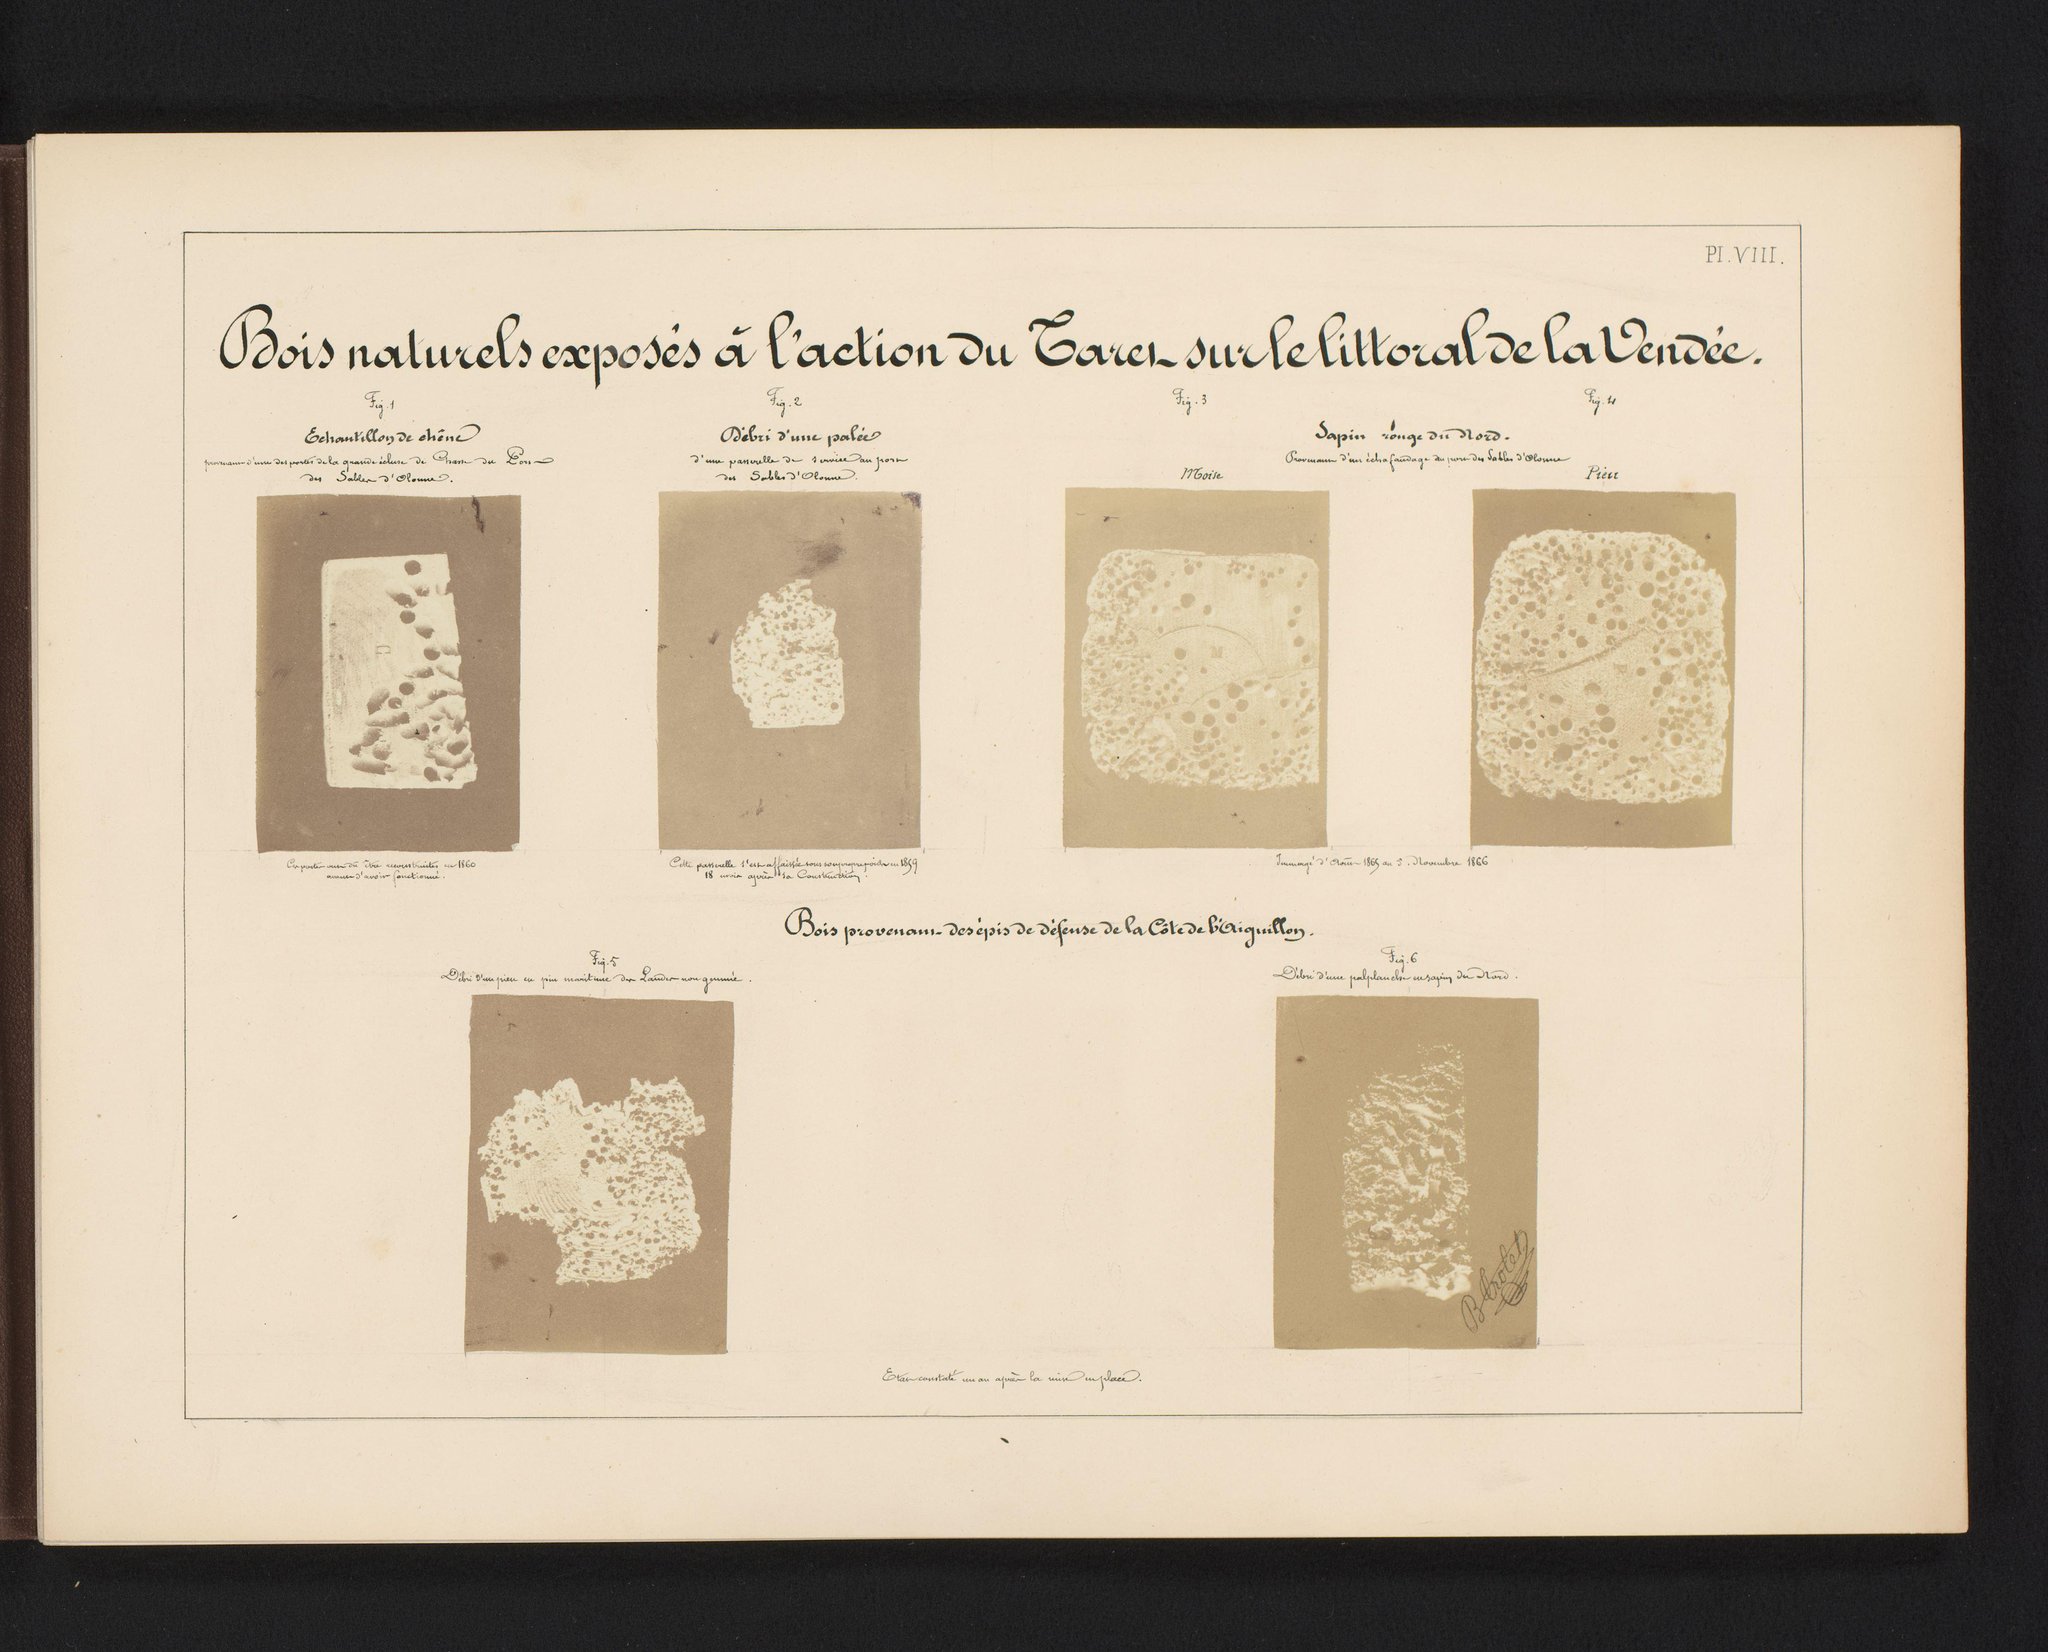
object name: photograph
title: Bois naturels exposés à l'action du Taret sur le littoral de la Vendée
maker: b. crolet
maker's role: fotograaf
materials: cardboard, photographic support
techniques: albumen print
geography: france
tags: worms, wood, timber ~ building material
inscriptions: number: ‘Pl. VIII.’, signature: ‘B. Crolet’, annotation: ‘Fig. 1/ Echantillon de chêne/ (...) mise en place.’